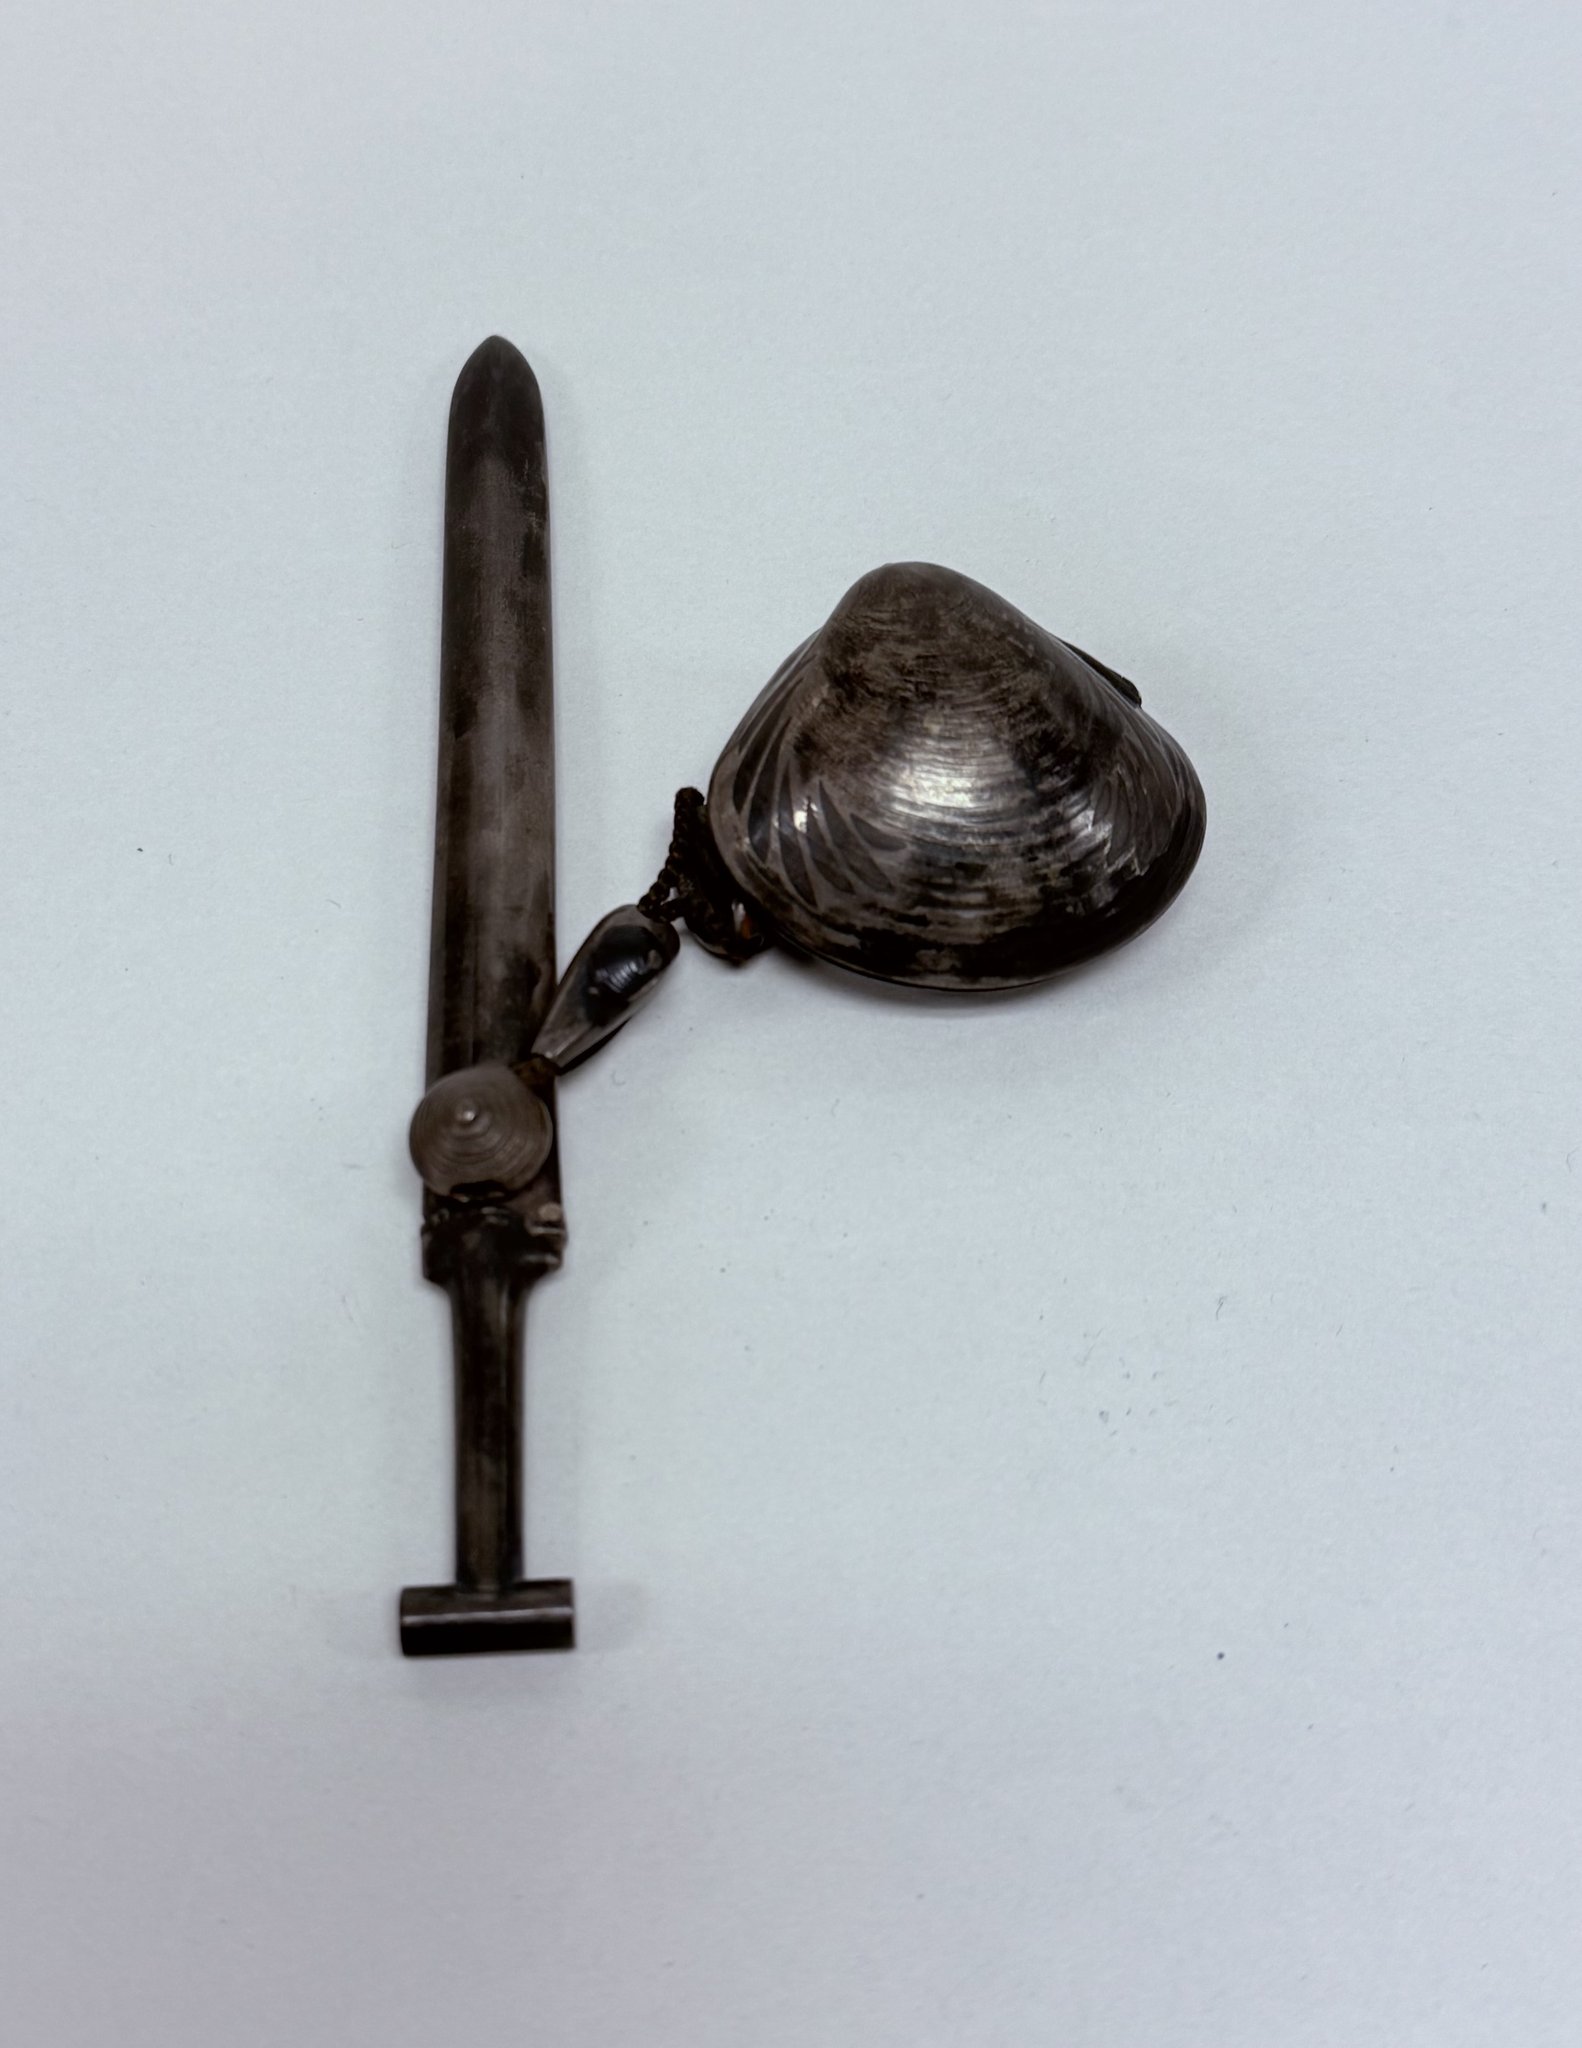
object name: pen holder and ink pad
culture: japanese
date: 1801-1900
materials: metal